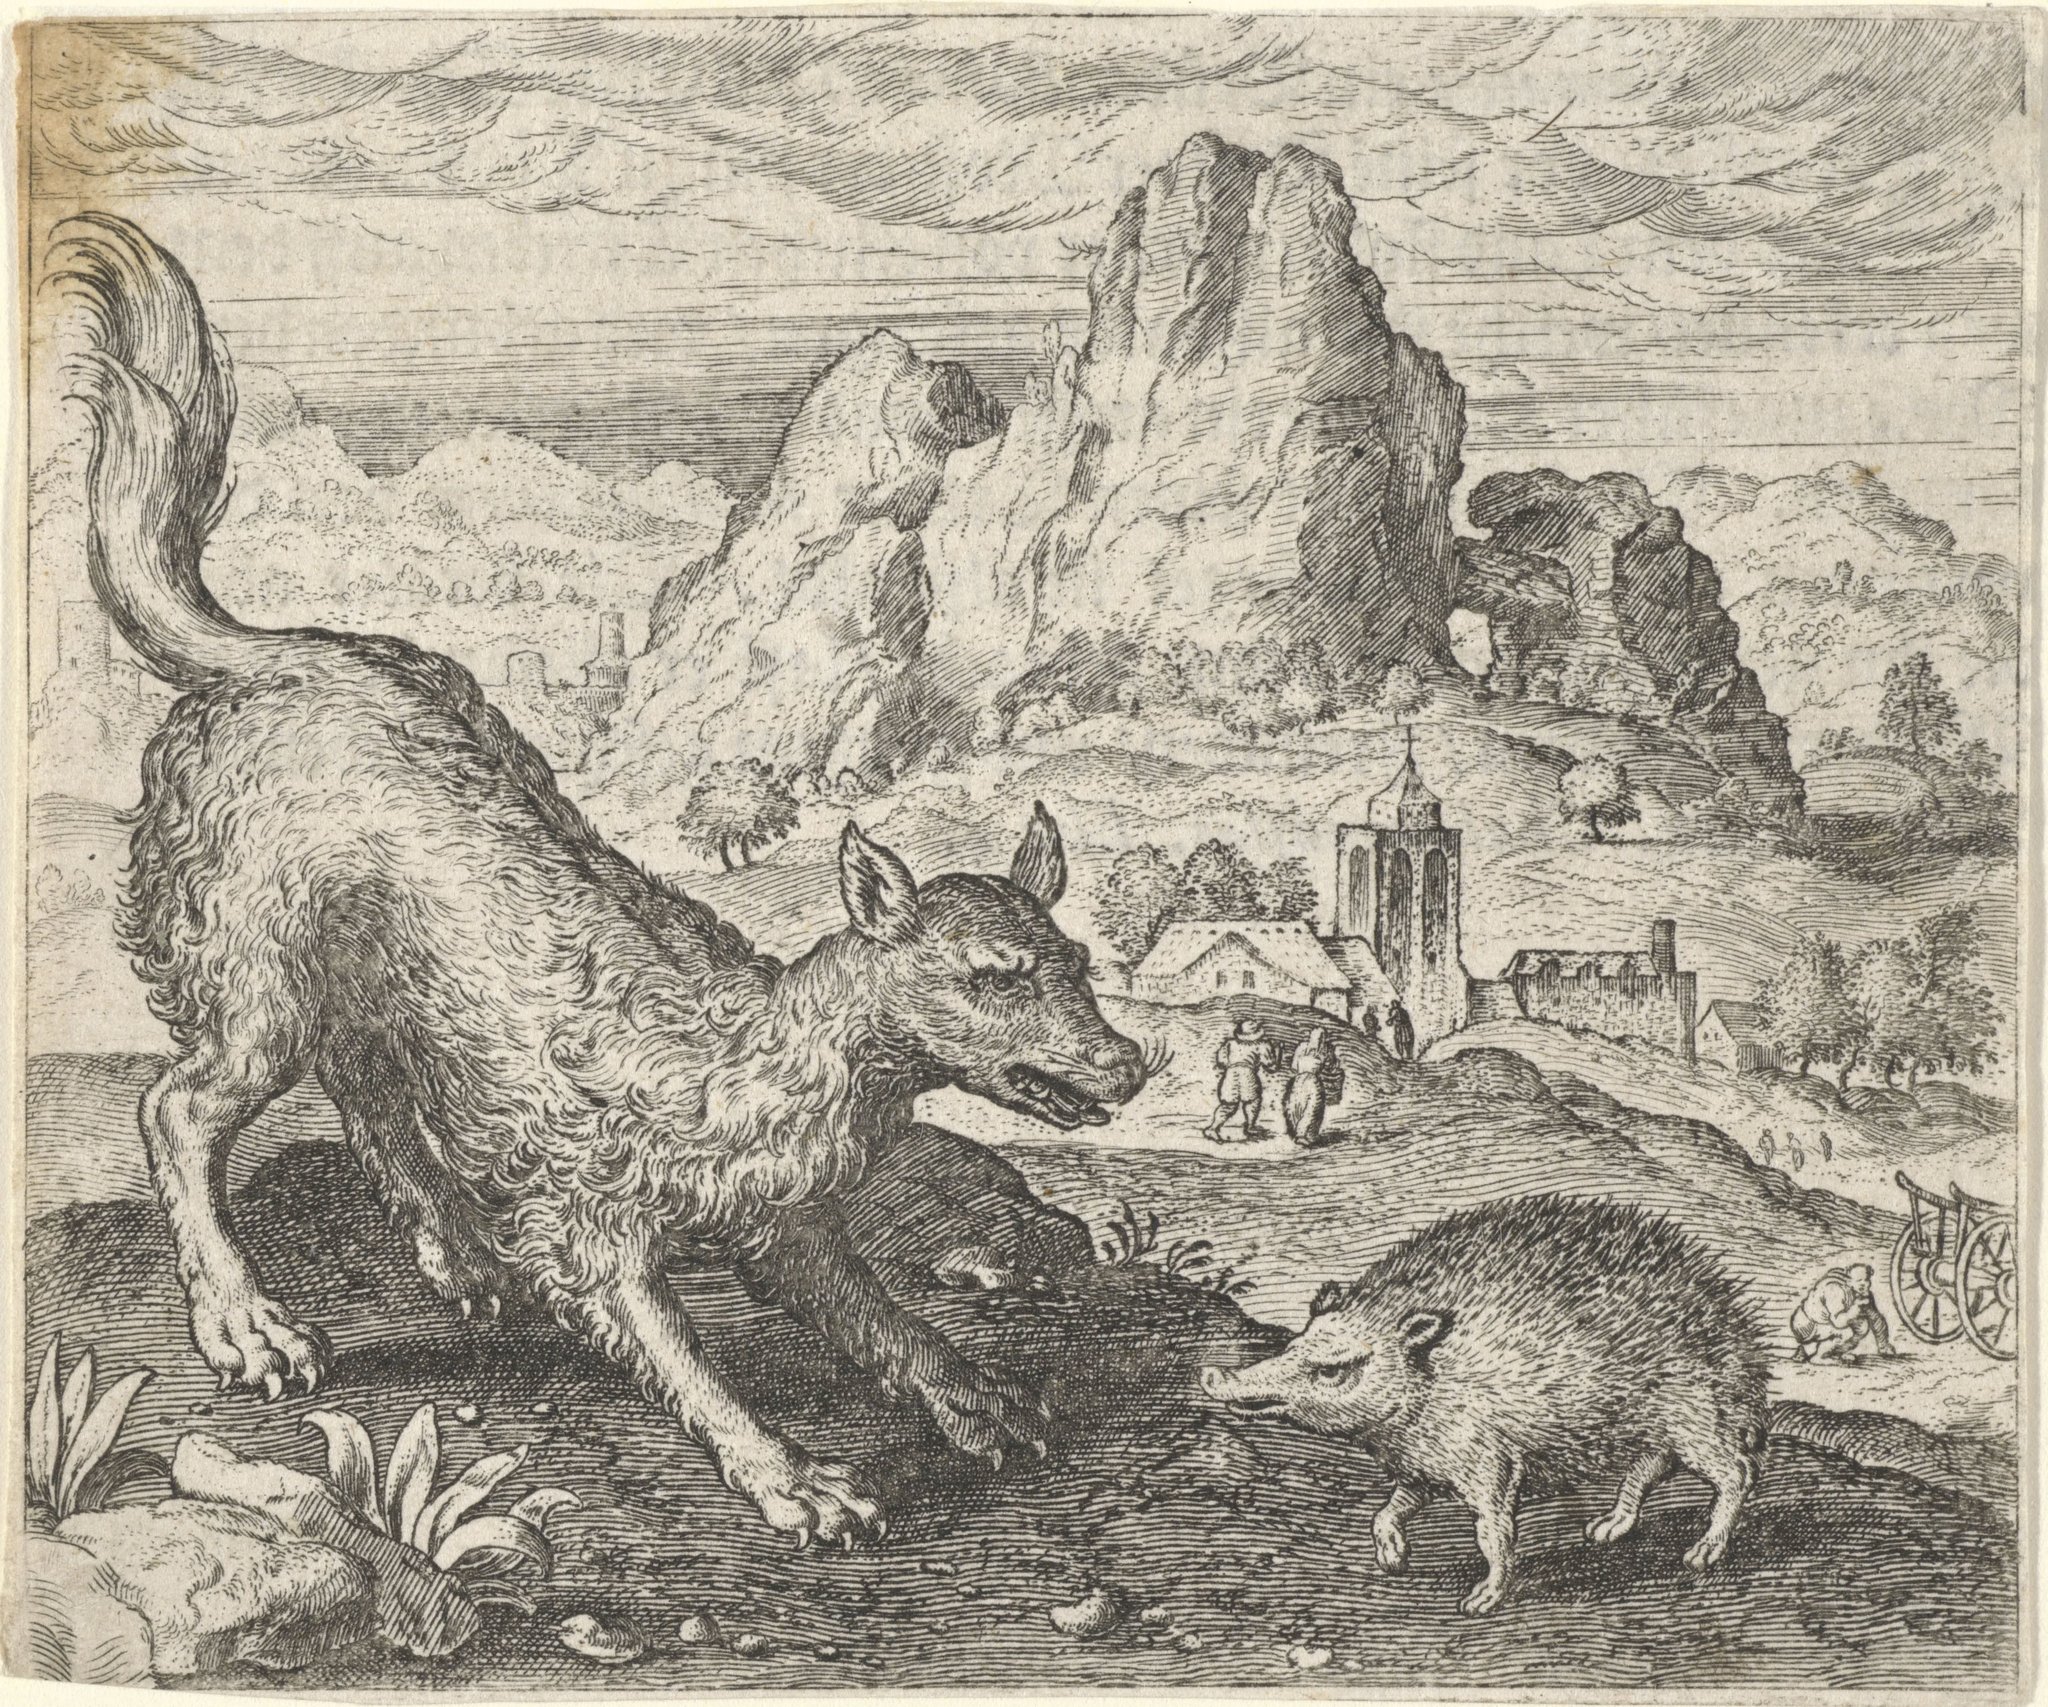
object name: book illustration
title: Fabel van de wolf en de egel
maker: aegidius sadeler (ii)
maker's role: draughtsman, print maker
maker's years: 1568-1629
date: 1608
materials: paper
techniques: engraving, etching, letterpress printing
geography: prague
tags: fables, other mammals: hedgehog, beasts of prey, predatory animals: wolf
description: Een wolf en een egel staan tegenover elkaar. De fabel beschrijft hoe een wolf tracht een egel te overtuigen zijn stekels terug te trekken. De moraal van het verhaal leert dat men nooit vijanden mag vertrouwen.